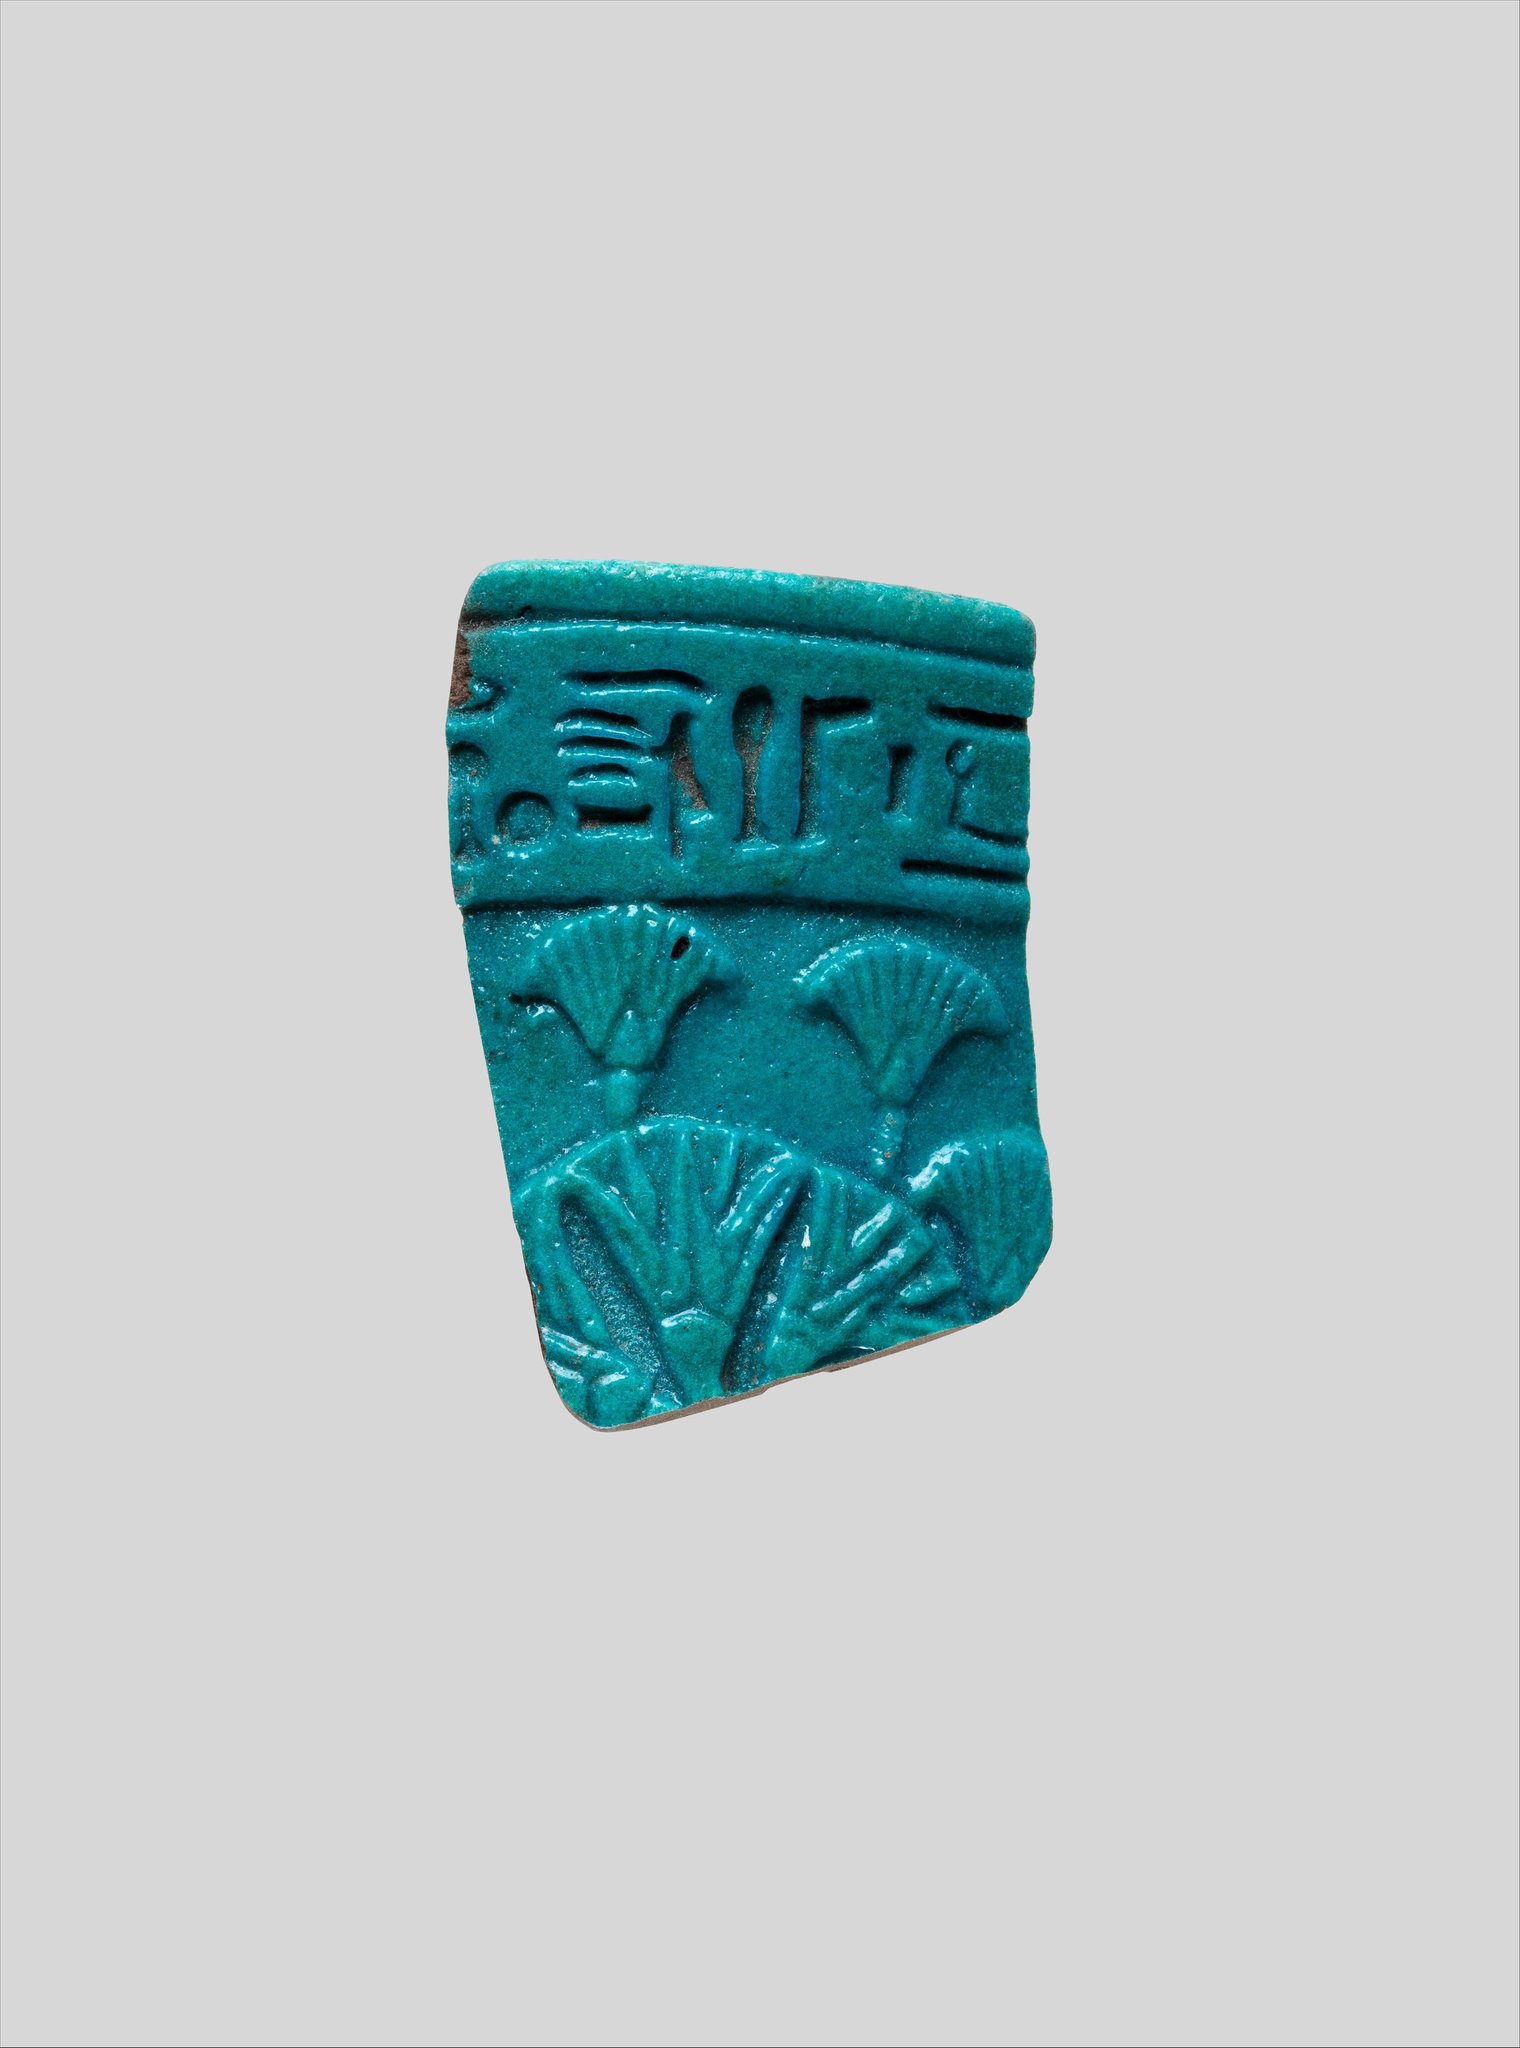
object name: chalice, cup, lotiform, relief, inscription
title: Rim fragment of relief chalice with inscription and papyrus plants, associated with 1983.599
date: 945-712 BCE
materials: faience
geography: egypt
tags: plants